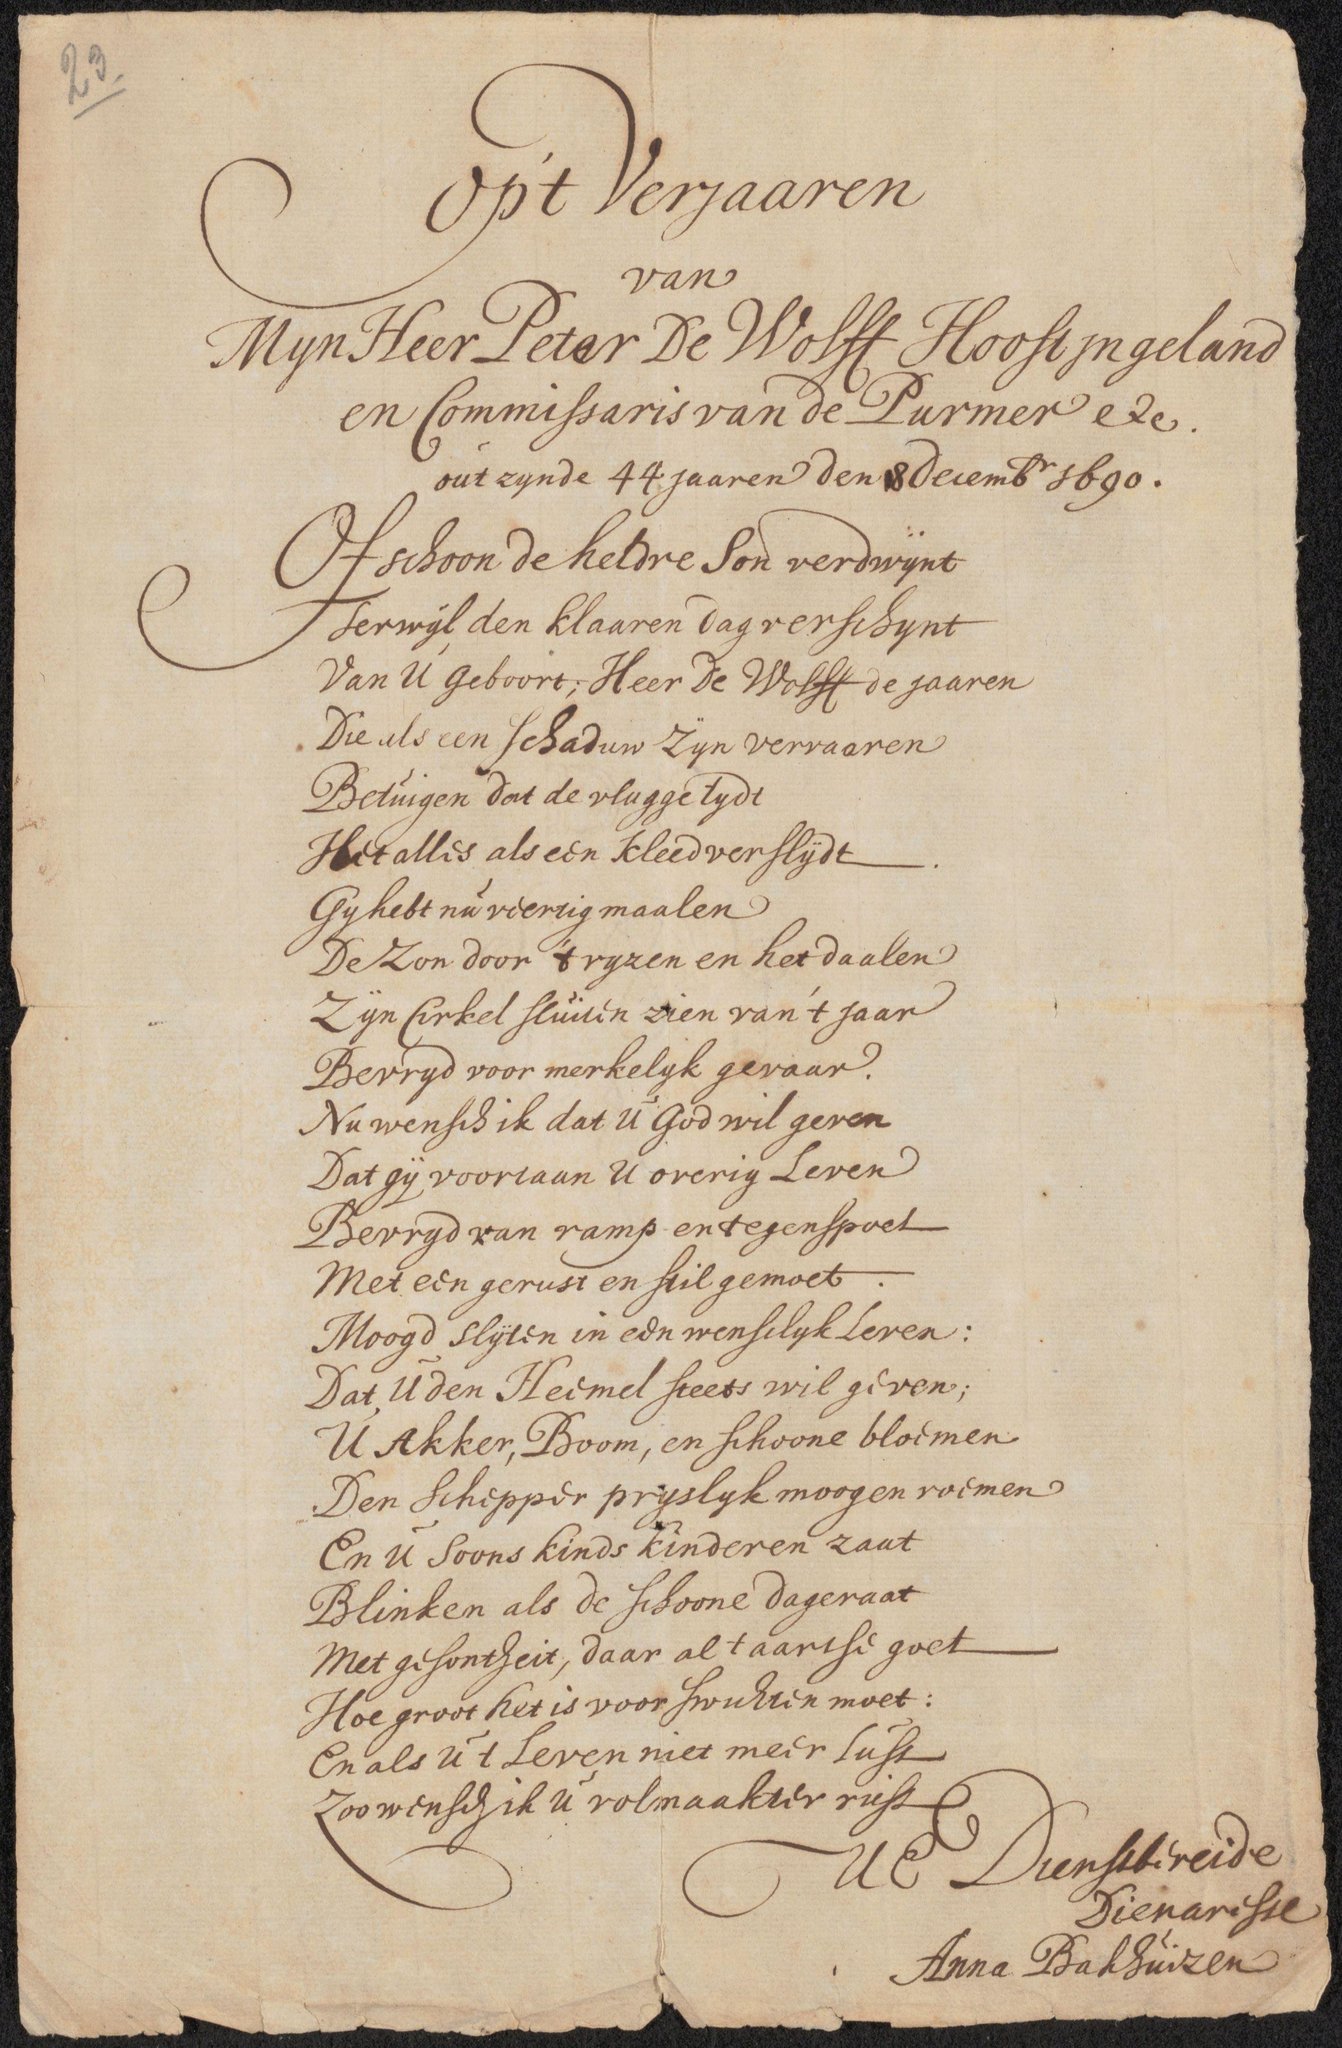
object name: poem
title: Gedicht op de verjaardag van Peter de Wolff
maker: anna de hooghe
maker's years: 1645-1717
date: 1690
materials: ink, paper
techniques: pen, writing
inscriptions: watermark, collector's mark: Lugt 2233